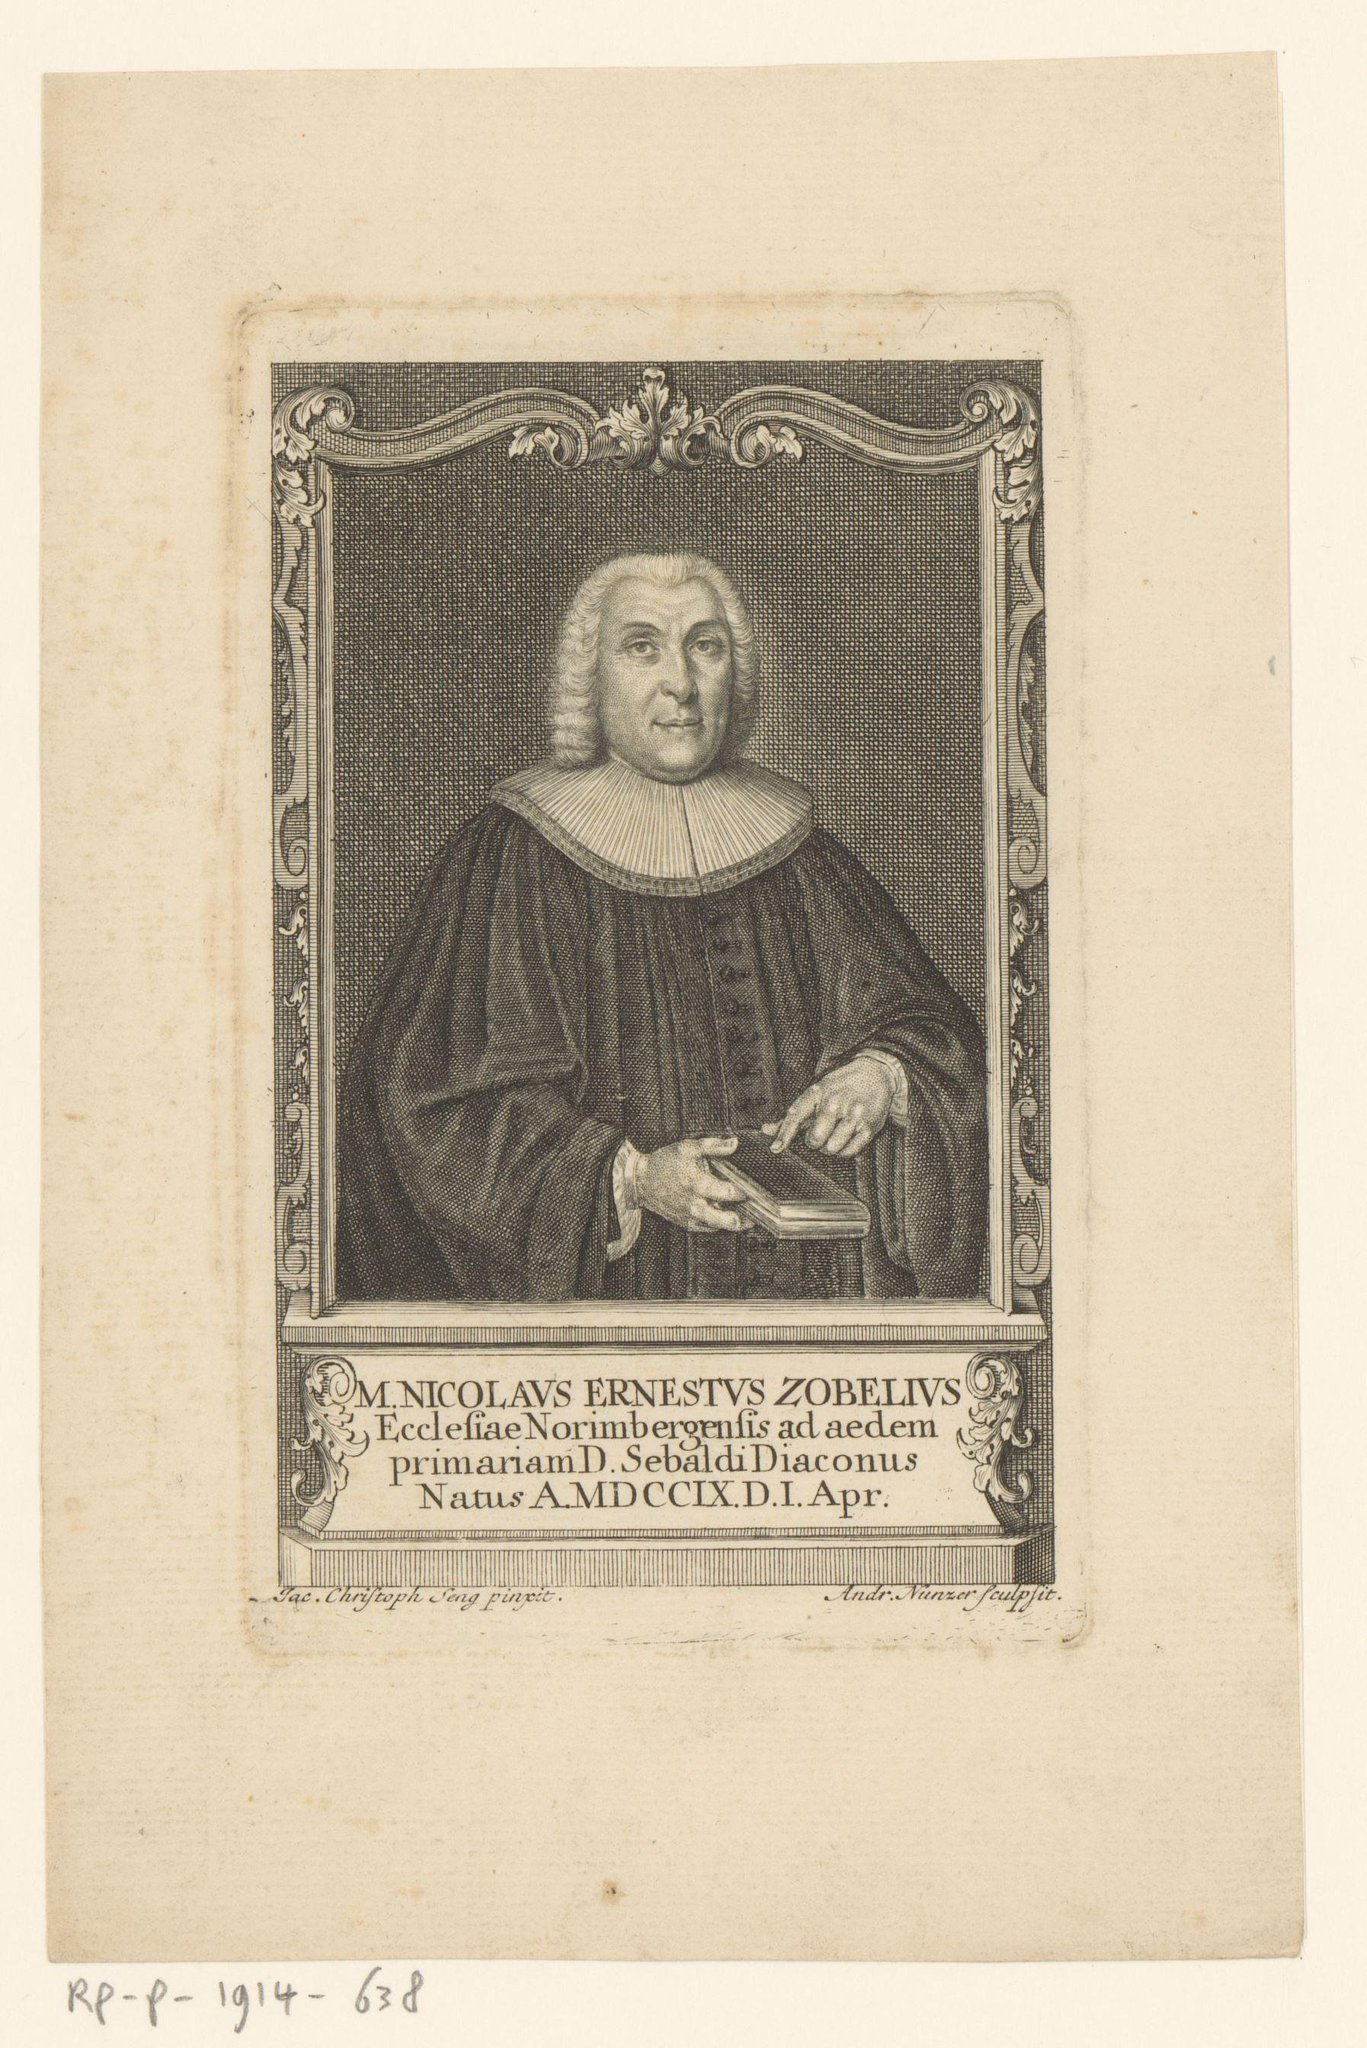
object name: print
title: Portret van Nicolaus Ernst Zobel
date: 1709-1749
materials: paper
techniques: engraving, etching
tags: historical persons, book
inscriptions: collector's mark: Lugt 2228